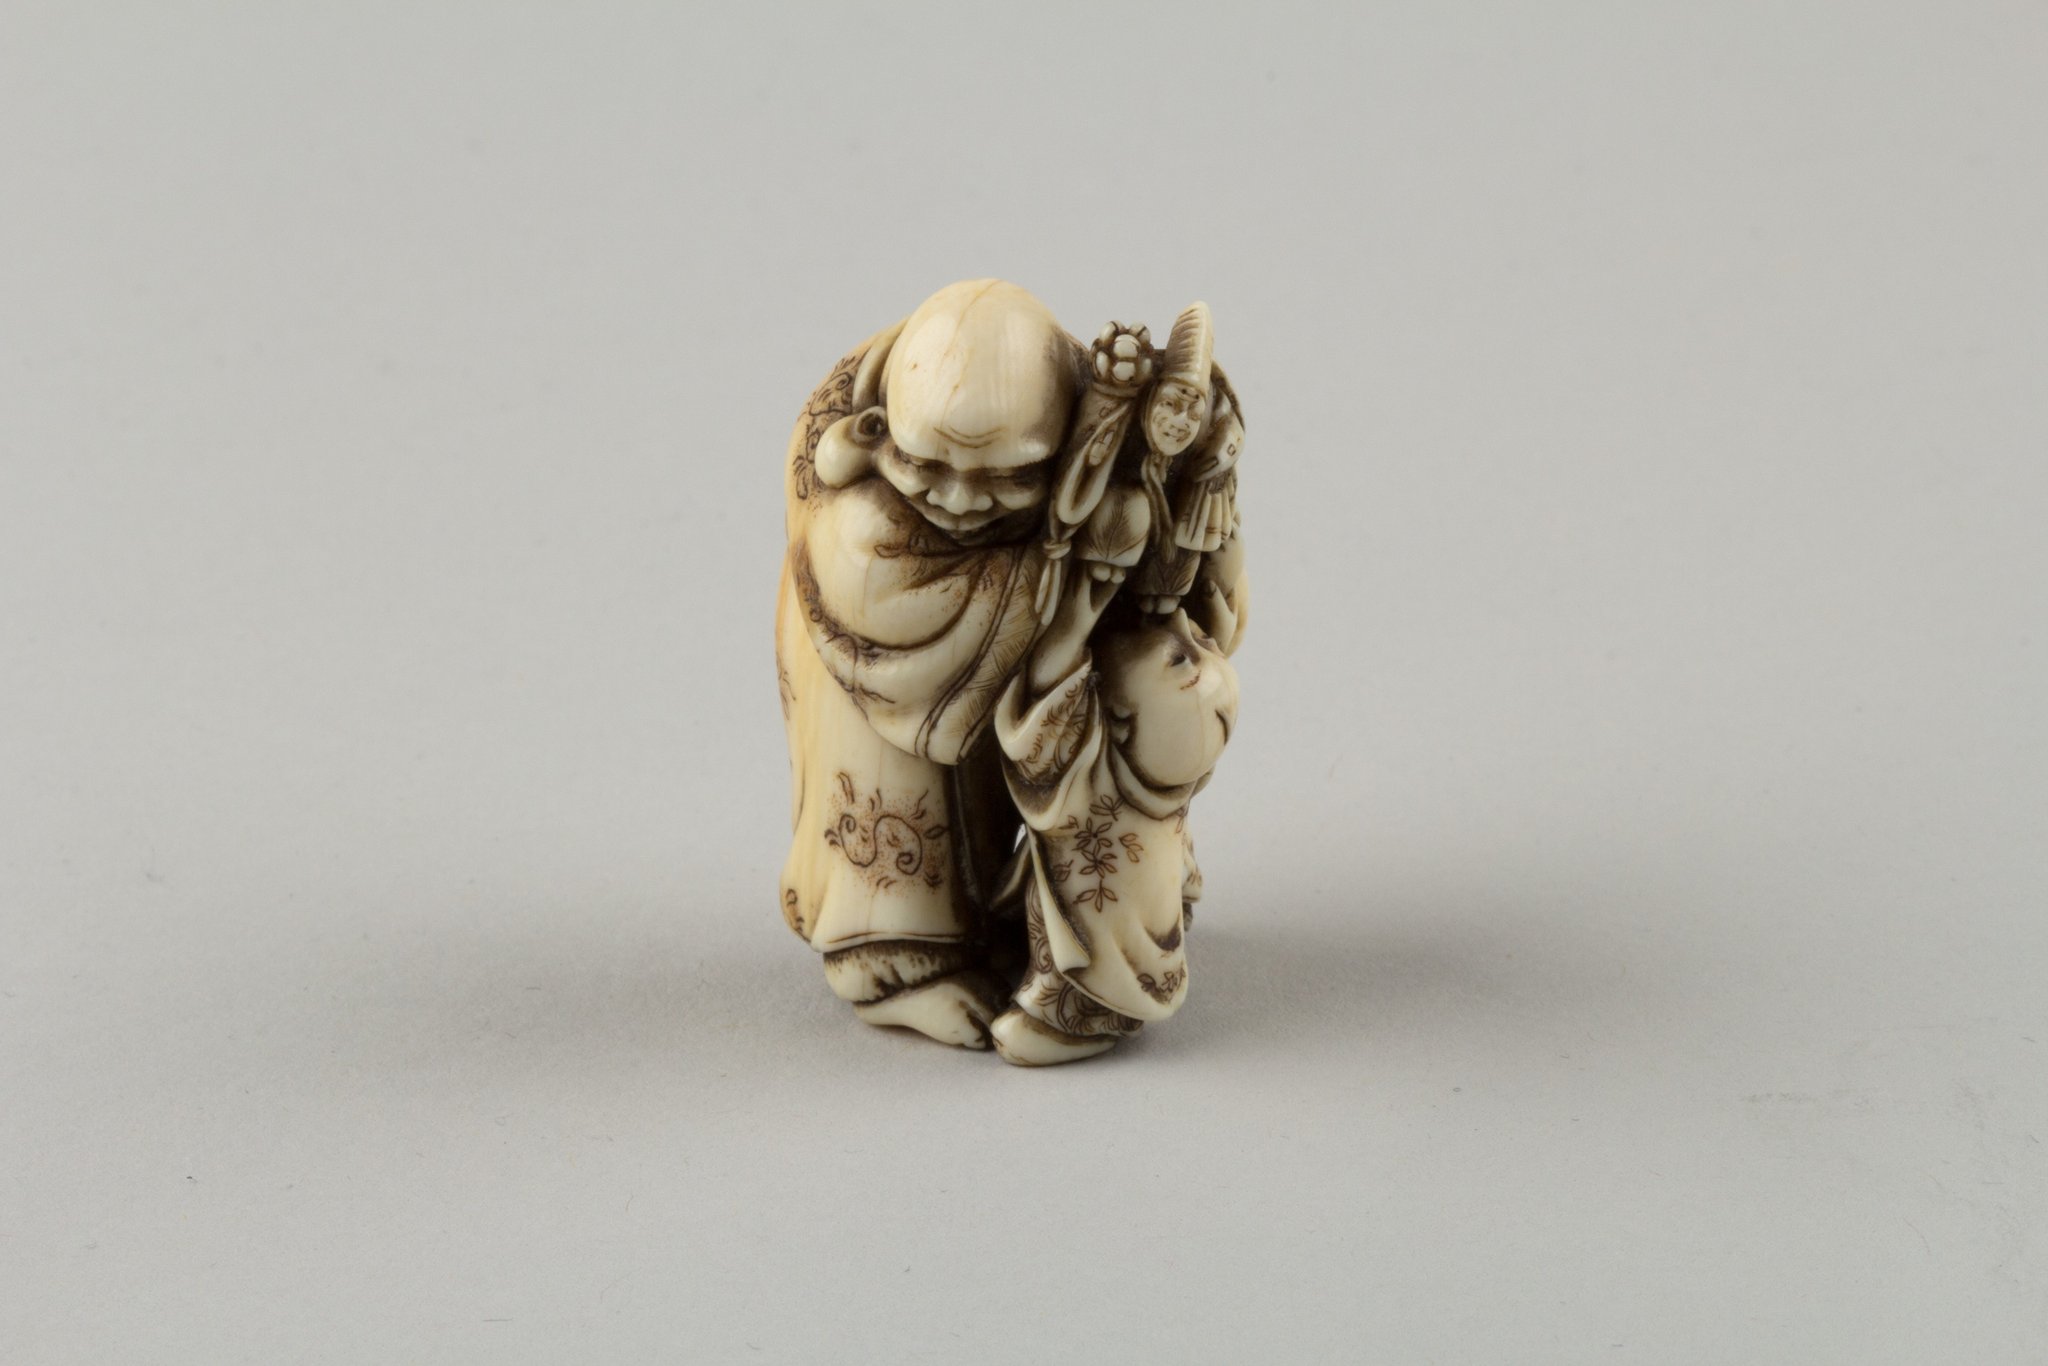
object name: netsuke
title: Netsuke of Man and Two Children with a Sambaso Dancer Puppet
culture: japanese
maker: masahide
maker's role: artist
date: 1801-1900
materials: ivory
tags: children,men,puppets